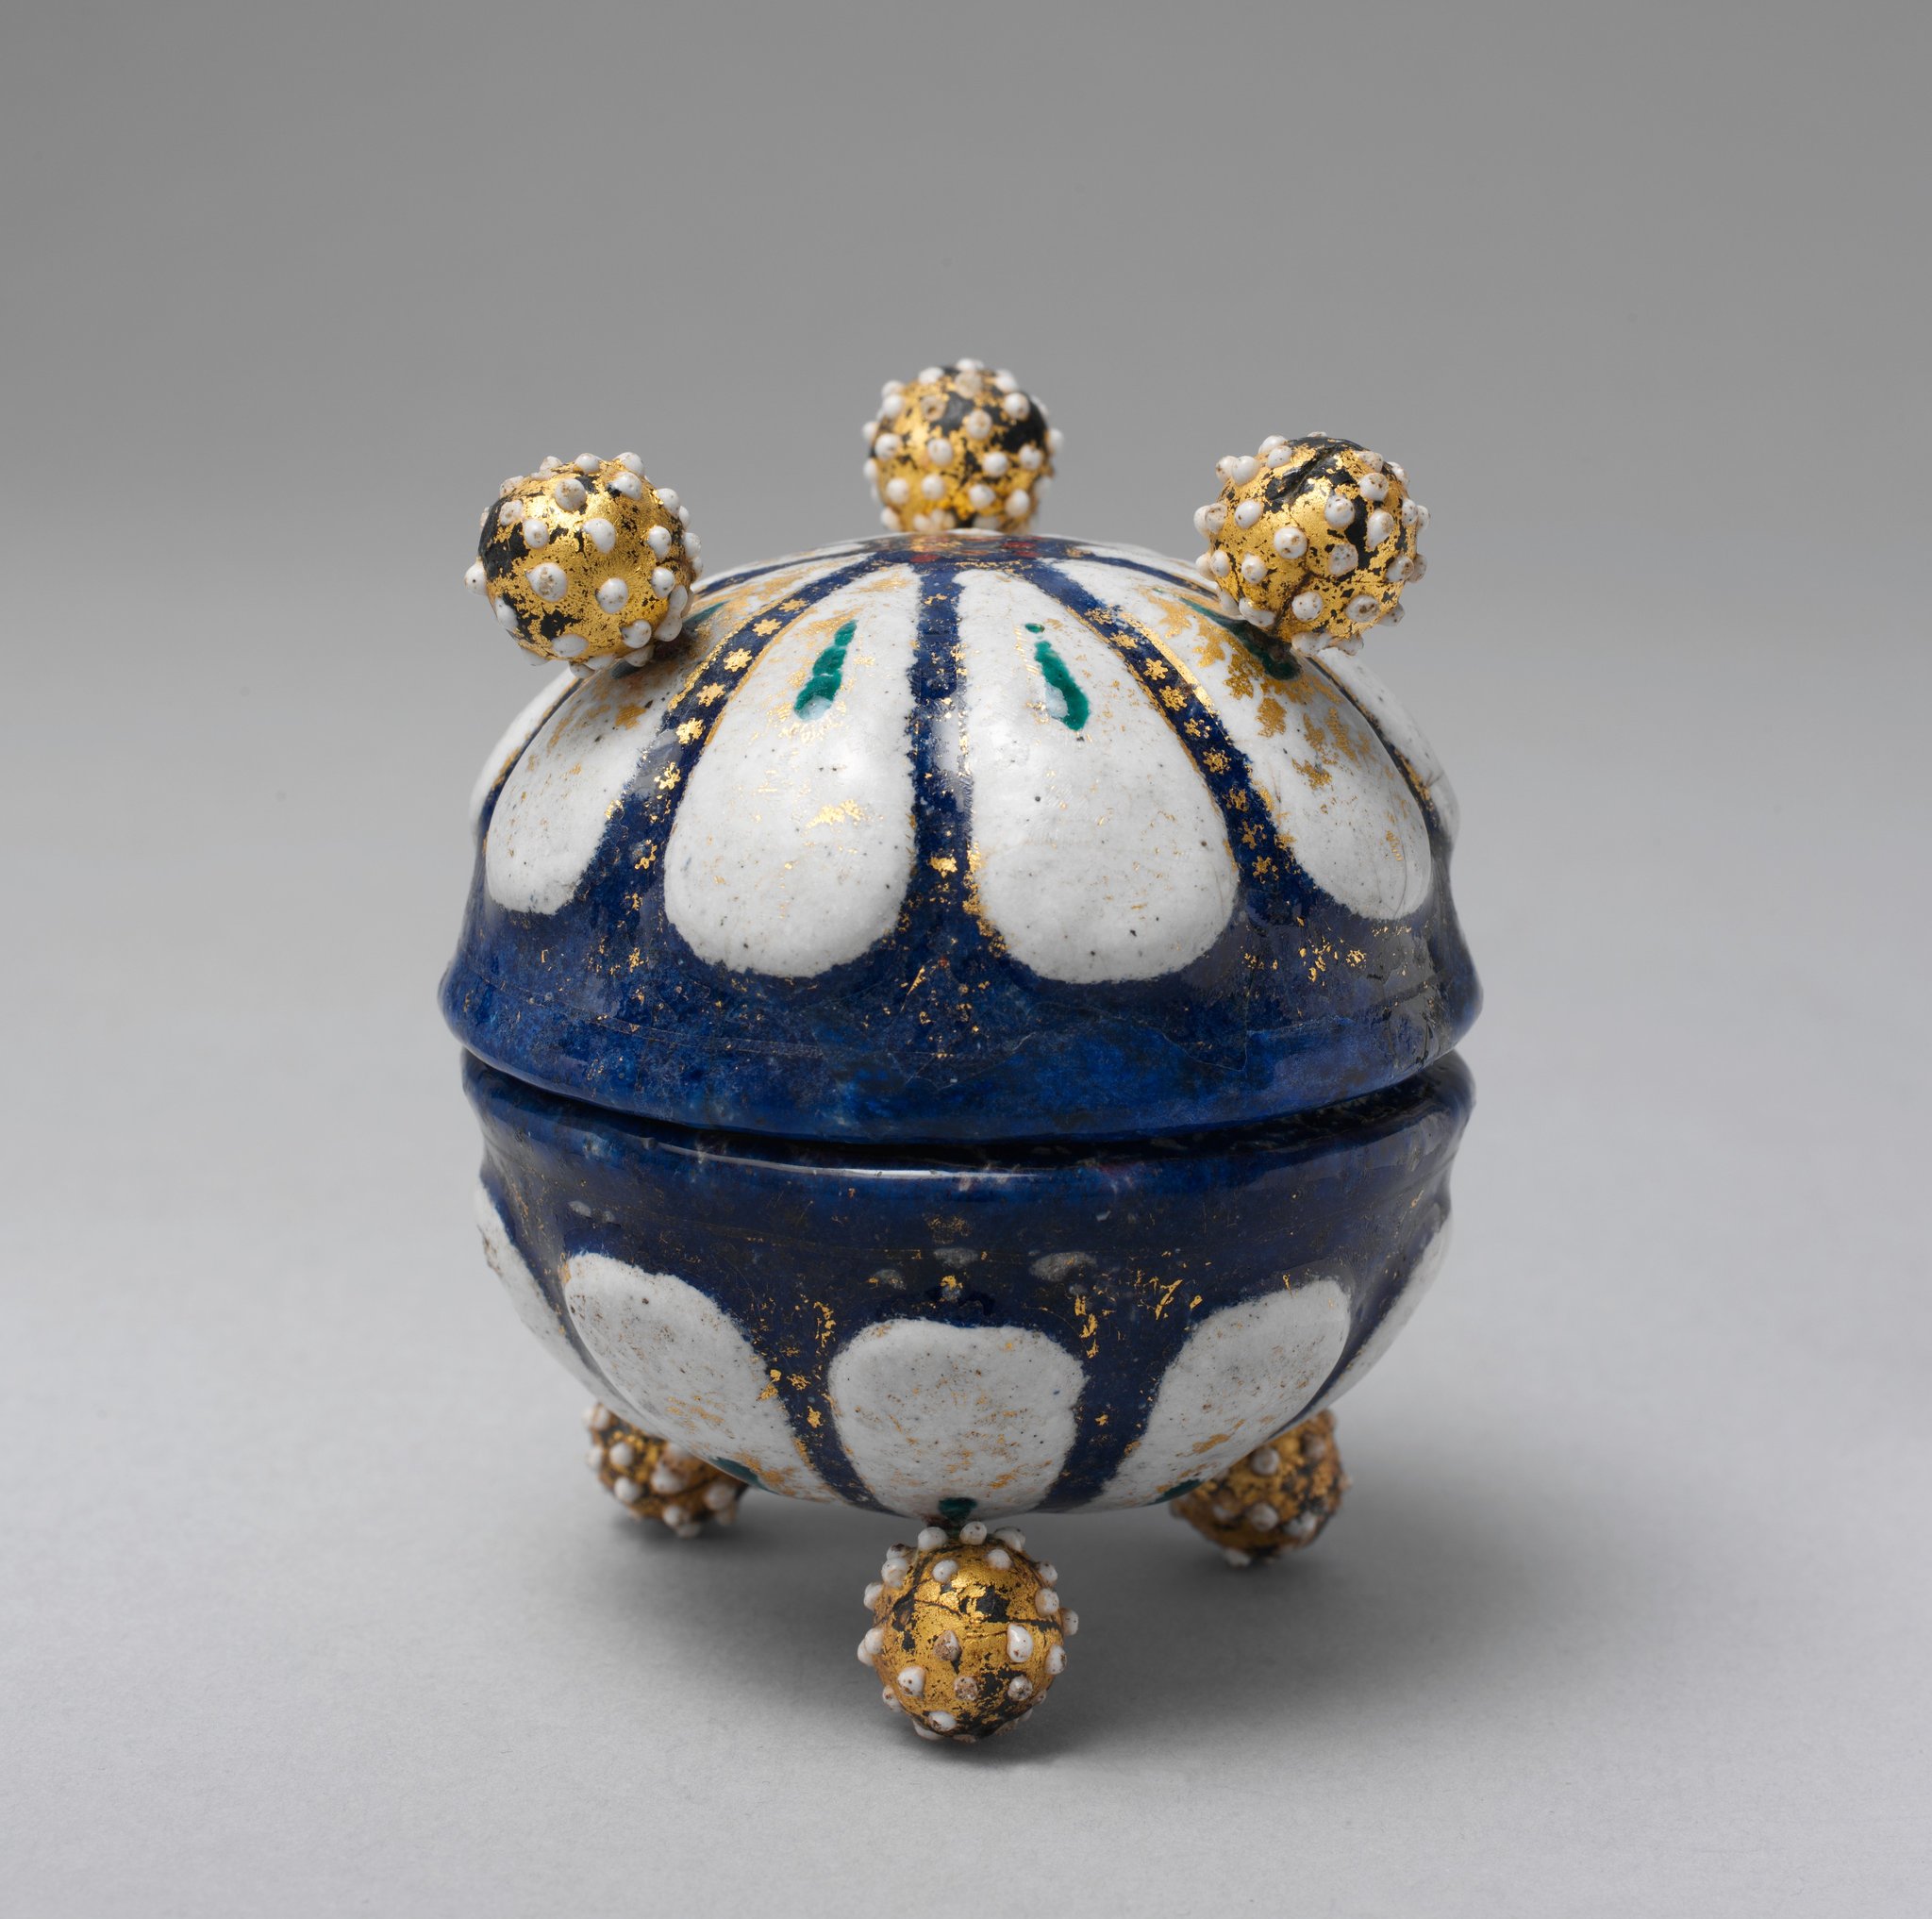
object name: toilet box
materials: copper, enamel, gilt, glass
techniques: painting